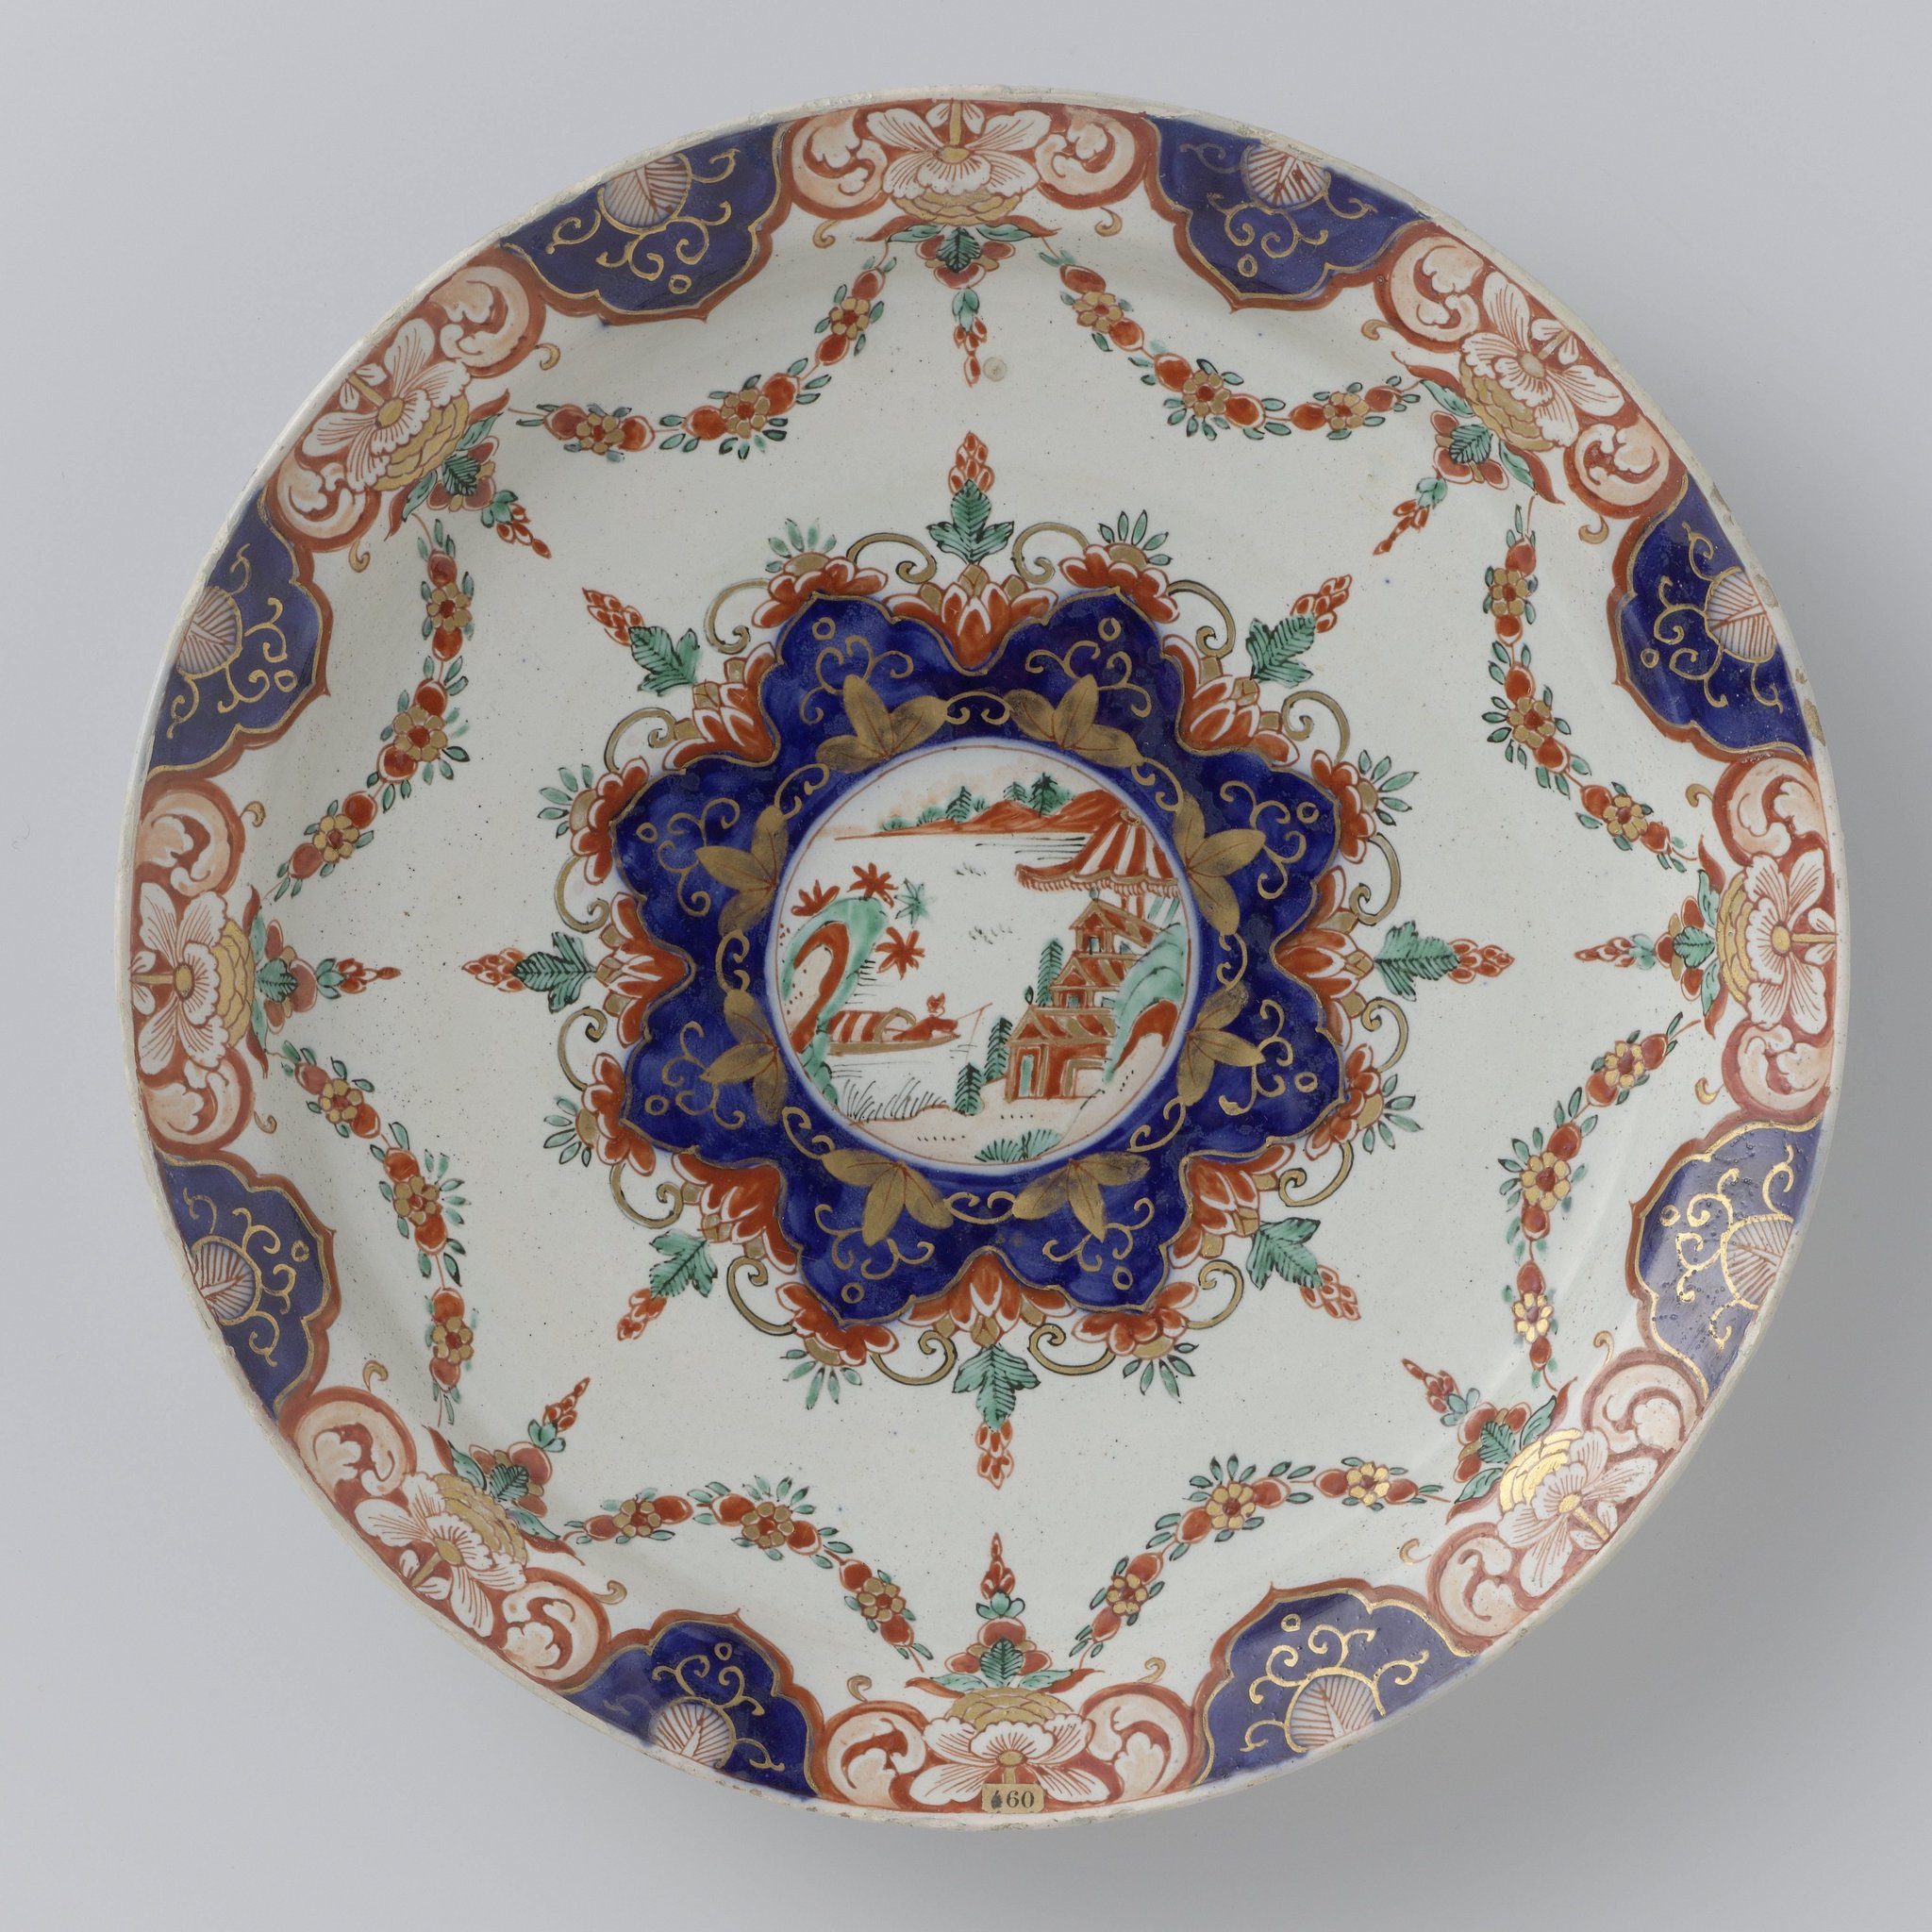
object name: plate dish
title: Bord van veelkleurig beschilderde faïence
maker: Anonymous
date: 1700-1725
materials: faience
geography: delft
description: Bord van faïence. Veelkleurig beschilderd met een Chinees waterlandschap en lambrequins, in imari kleuren.